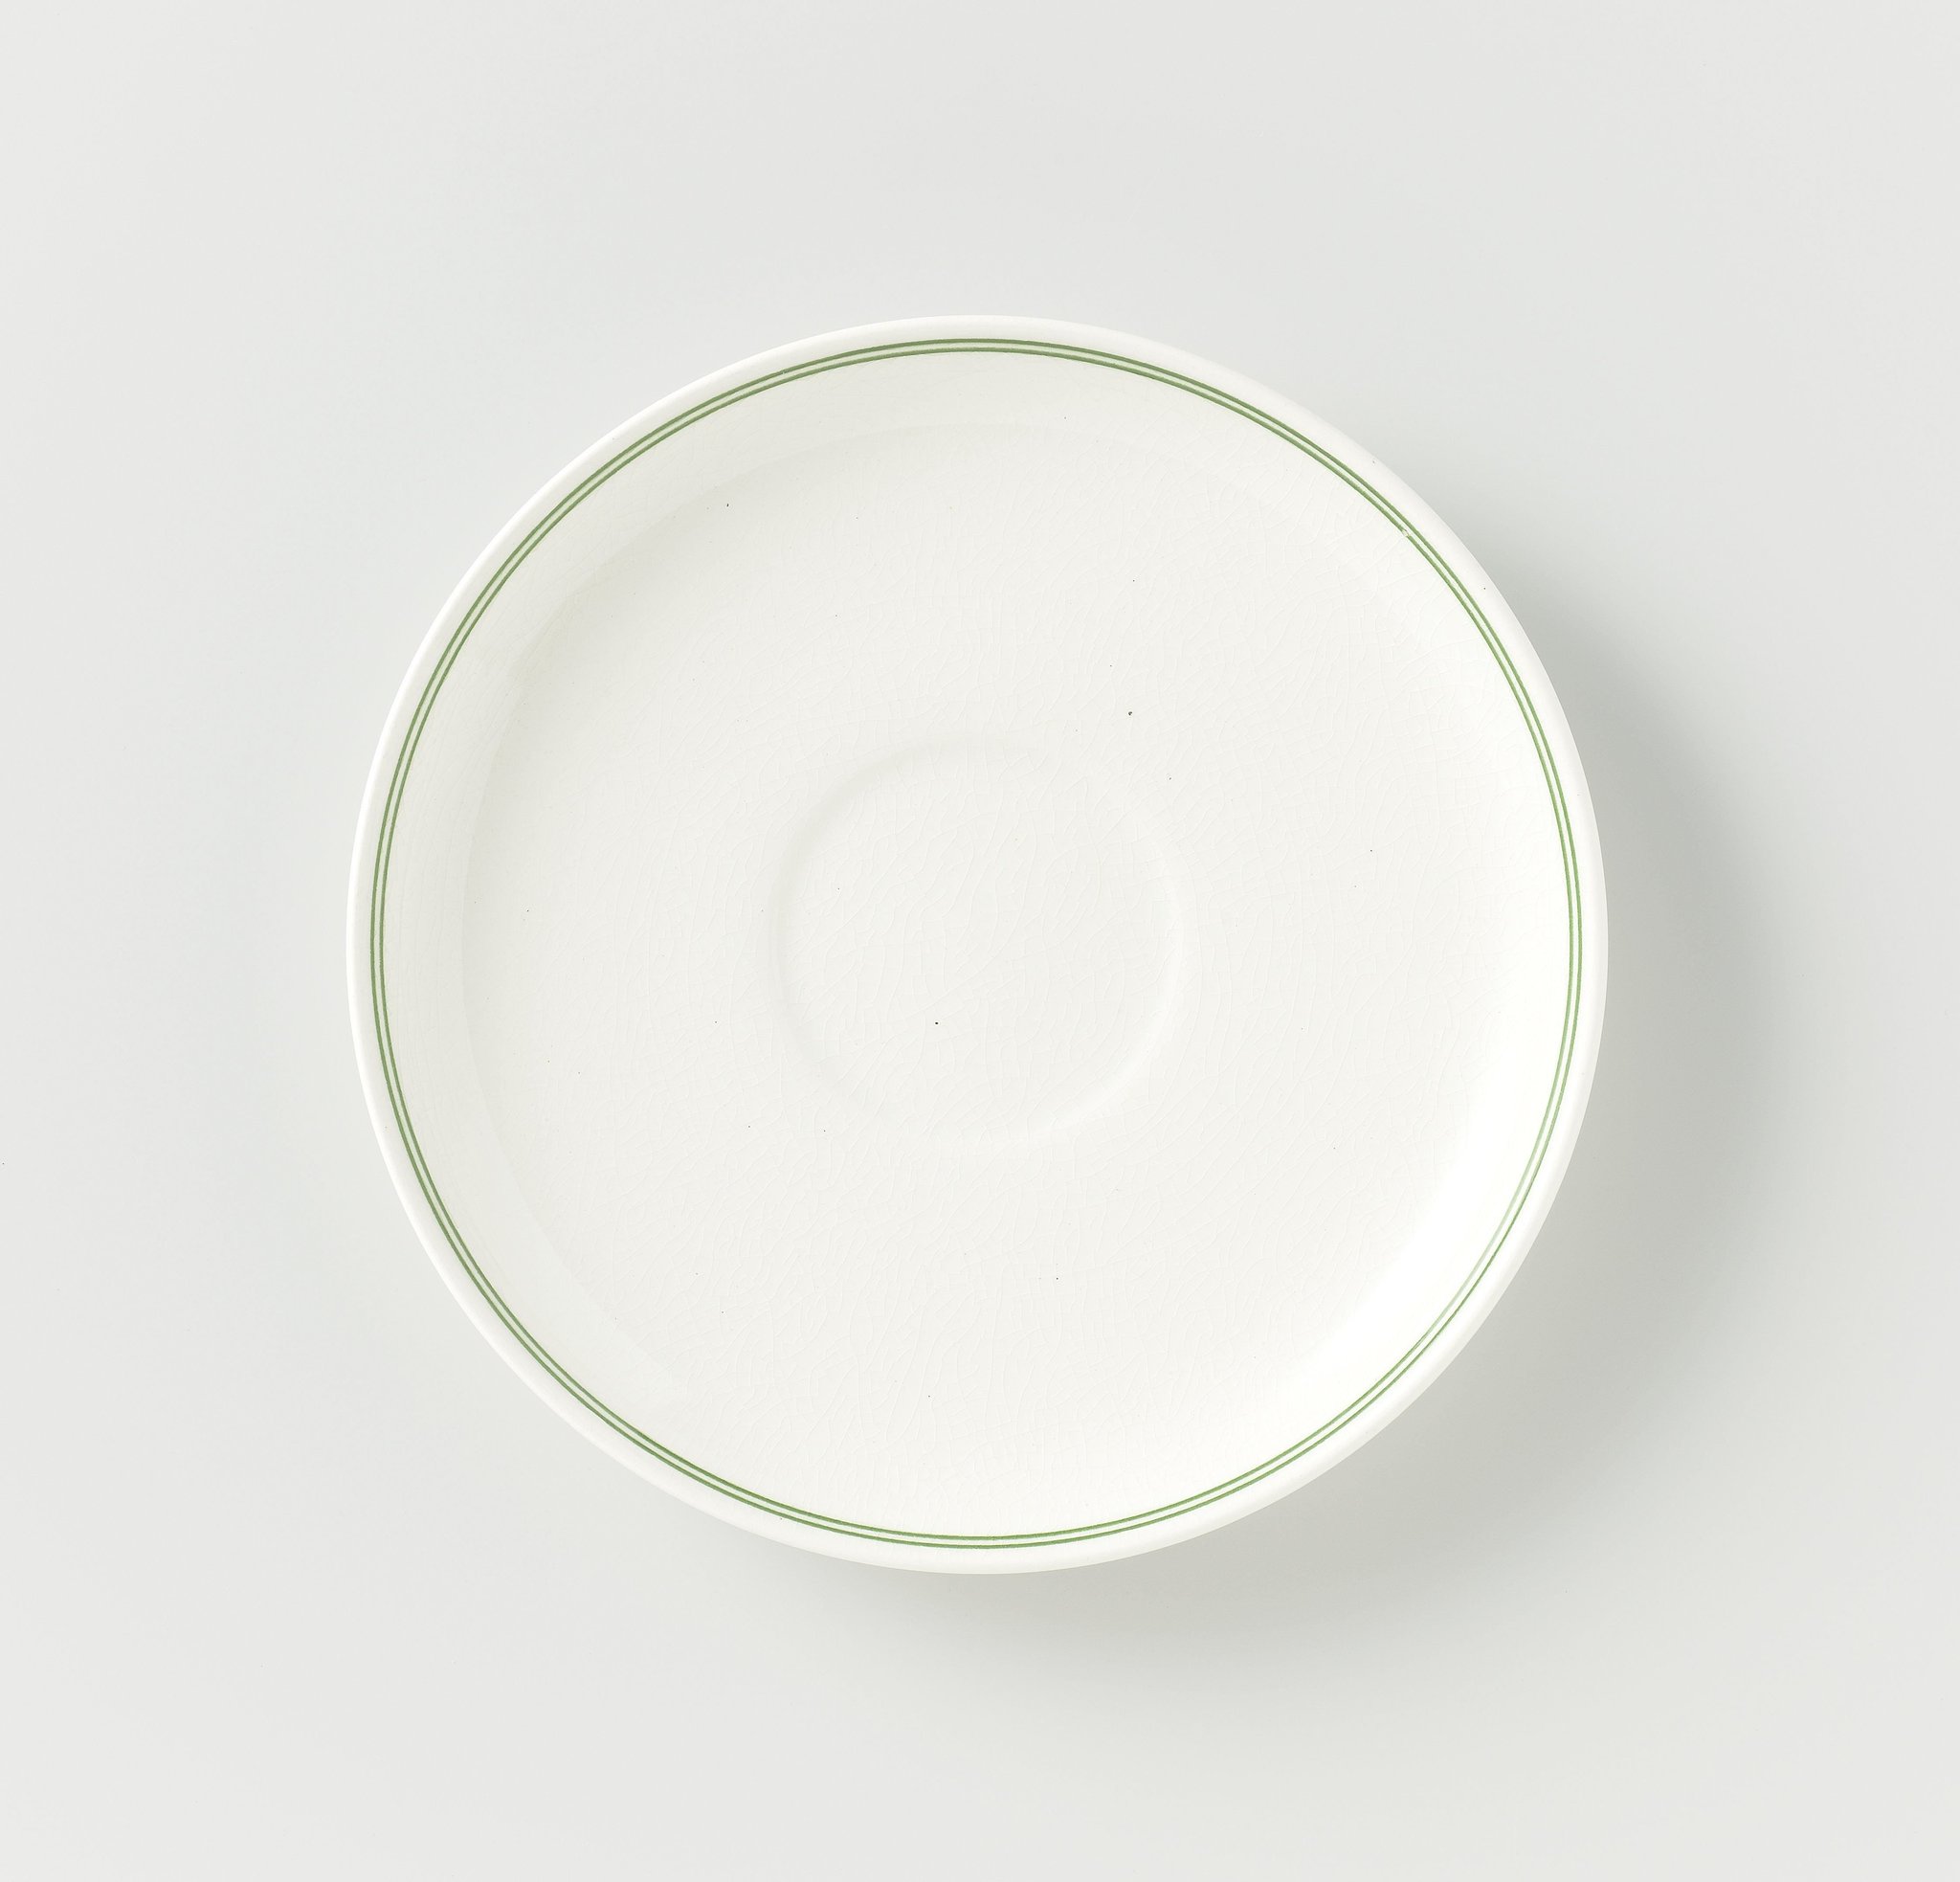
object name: service set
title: Schotel van aardewerk versierd met vierkanten in groen en geel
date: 1910-1920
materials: earthenware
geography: gouda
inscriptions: mark: ‘PLATEELBAKKERIJ.ZUID.HOLLAND ; een poort waarop staat GOUDA ; 4020.1000.J (in geel) ; 29 SIIA , N (ingegrift)’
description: Schotel van aardewerk versierd met vierkanten in groen en geel.